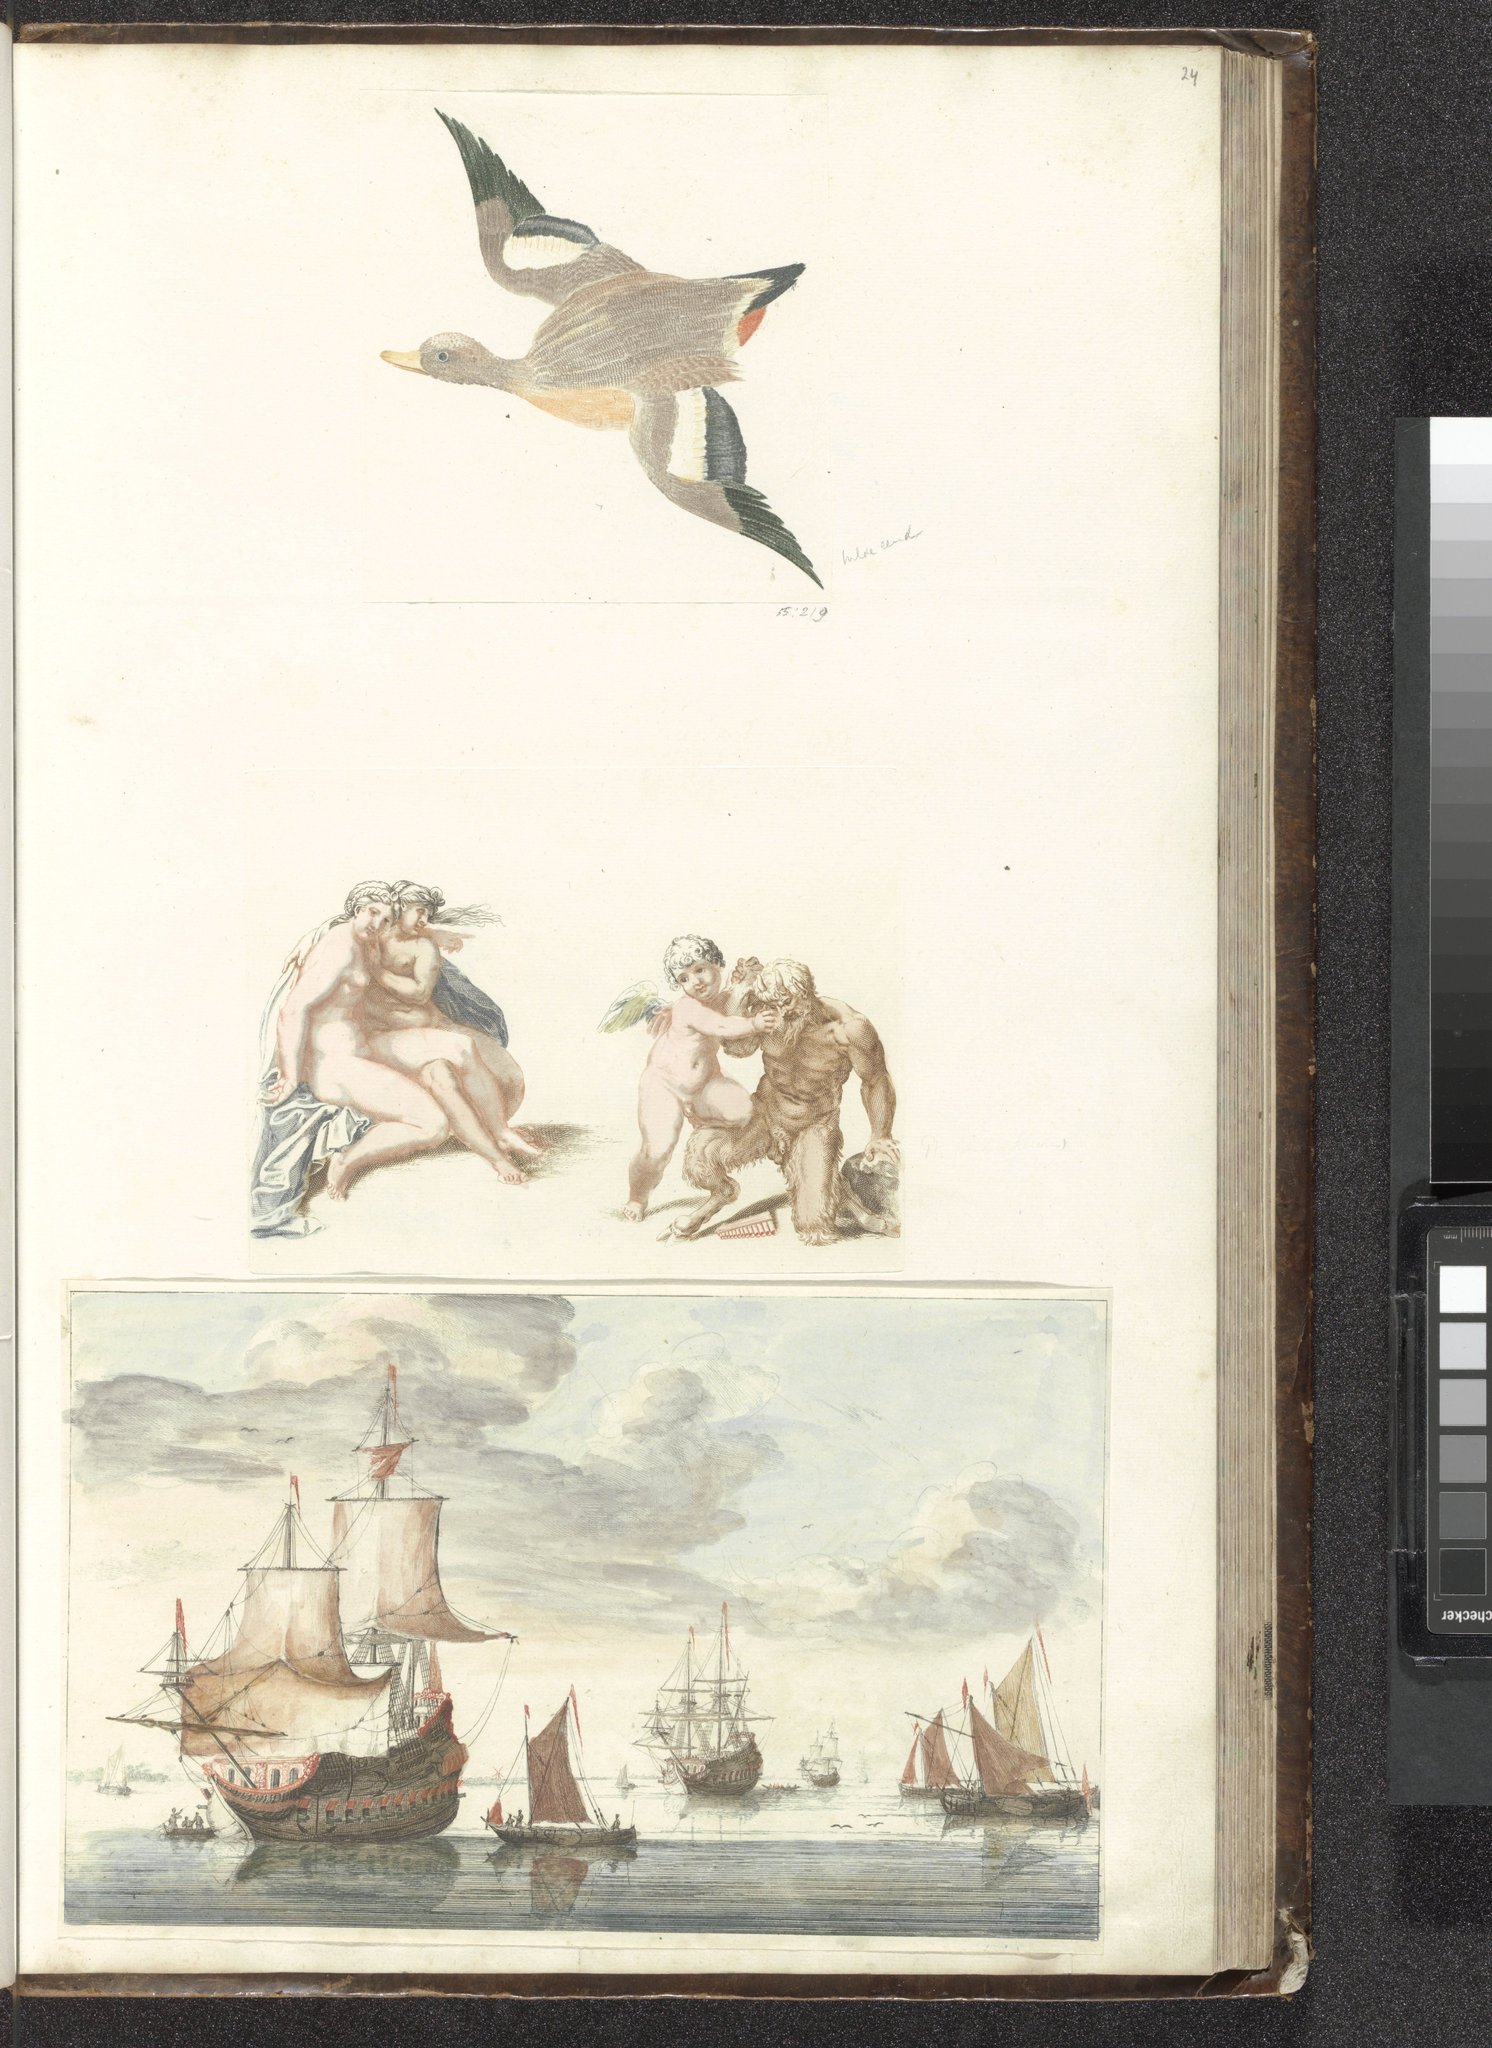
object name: album leaf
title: Amor bestraft een sater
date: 1688-1698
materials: paper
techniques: printing, engraving, hand coloring, lithography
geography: netherlands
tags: nymphs (in general); 'ninfe in commune' (ripa), satyr(s) (in general), (story of) cupid, amor (eros)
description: Amor bestraft een sater, die zijn panfluit op de grond heeft laten vallen. Daarnaast zitten twee nimfen, die vermoedelijk door de sater werden bespied. Deze prent maakt deel uit van een album.